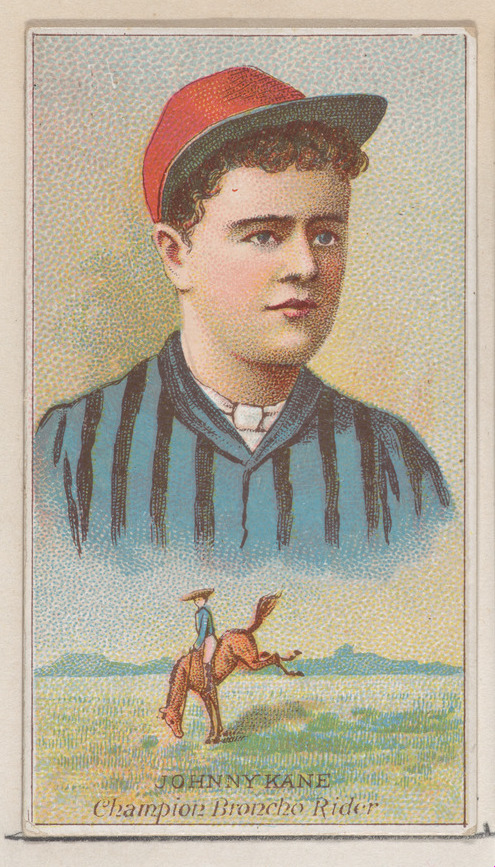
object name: print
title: Johnny Kane, Champion Bronco Rider, from the Champions of Games and Sports series (N184, Type 2) issued by W.S. Kimball & Co.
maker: w.s. kimball & co.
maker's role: publisher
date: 1887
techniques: color lithograph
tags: men,sports,athletes